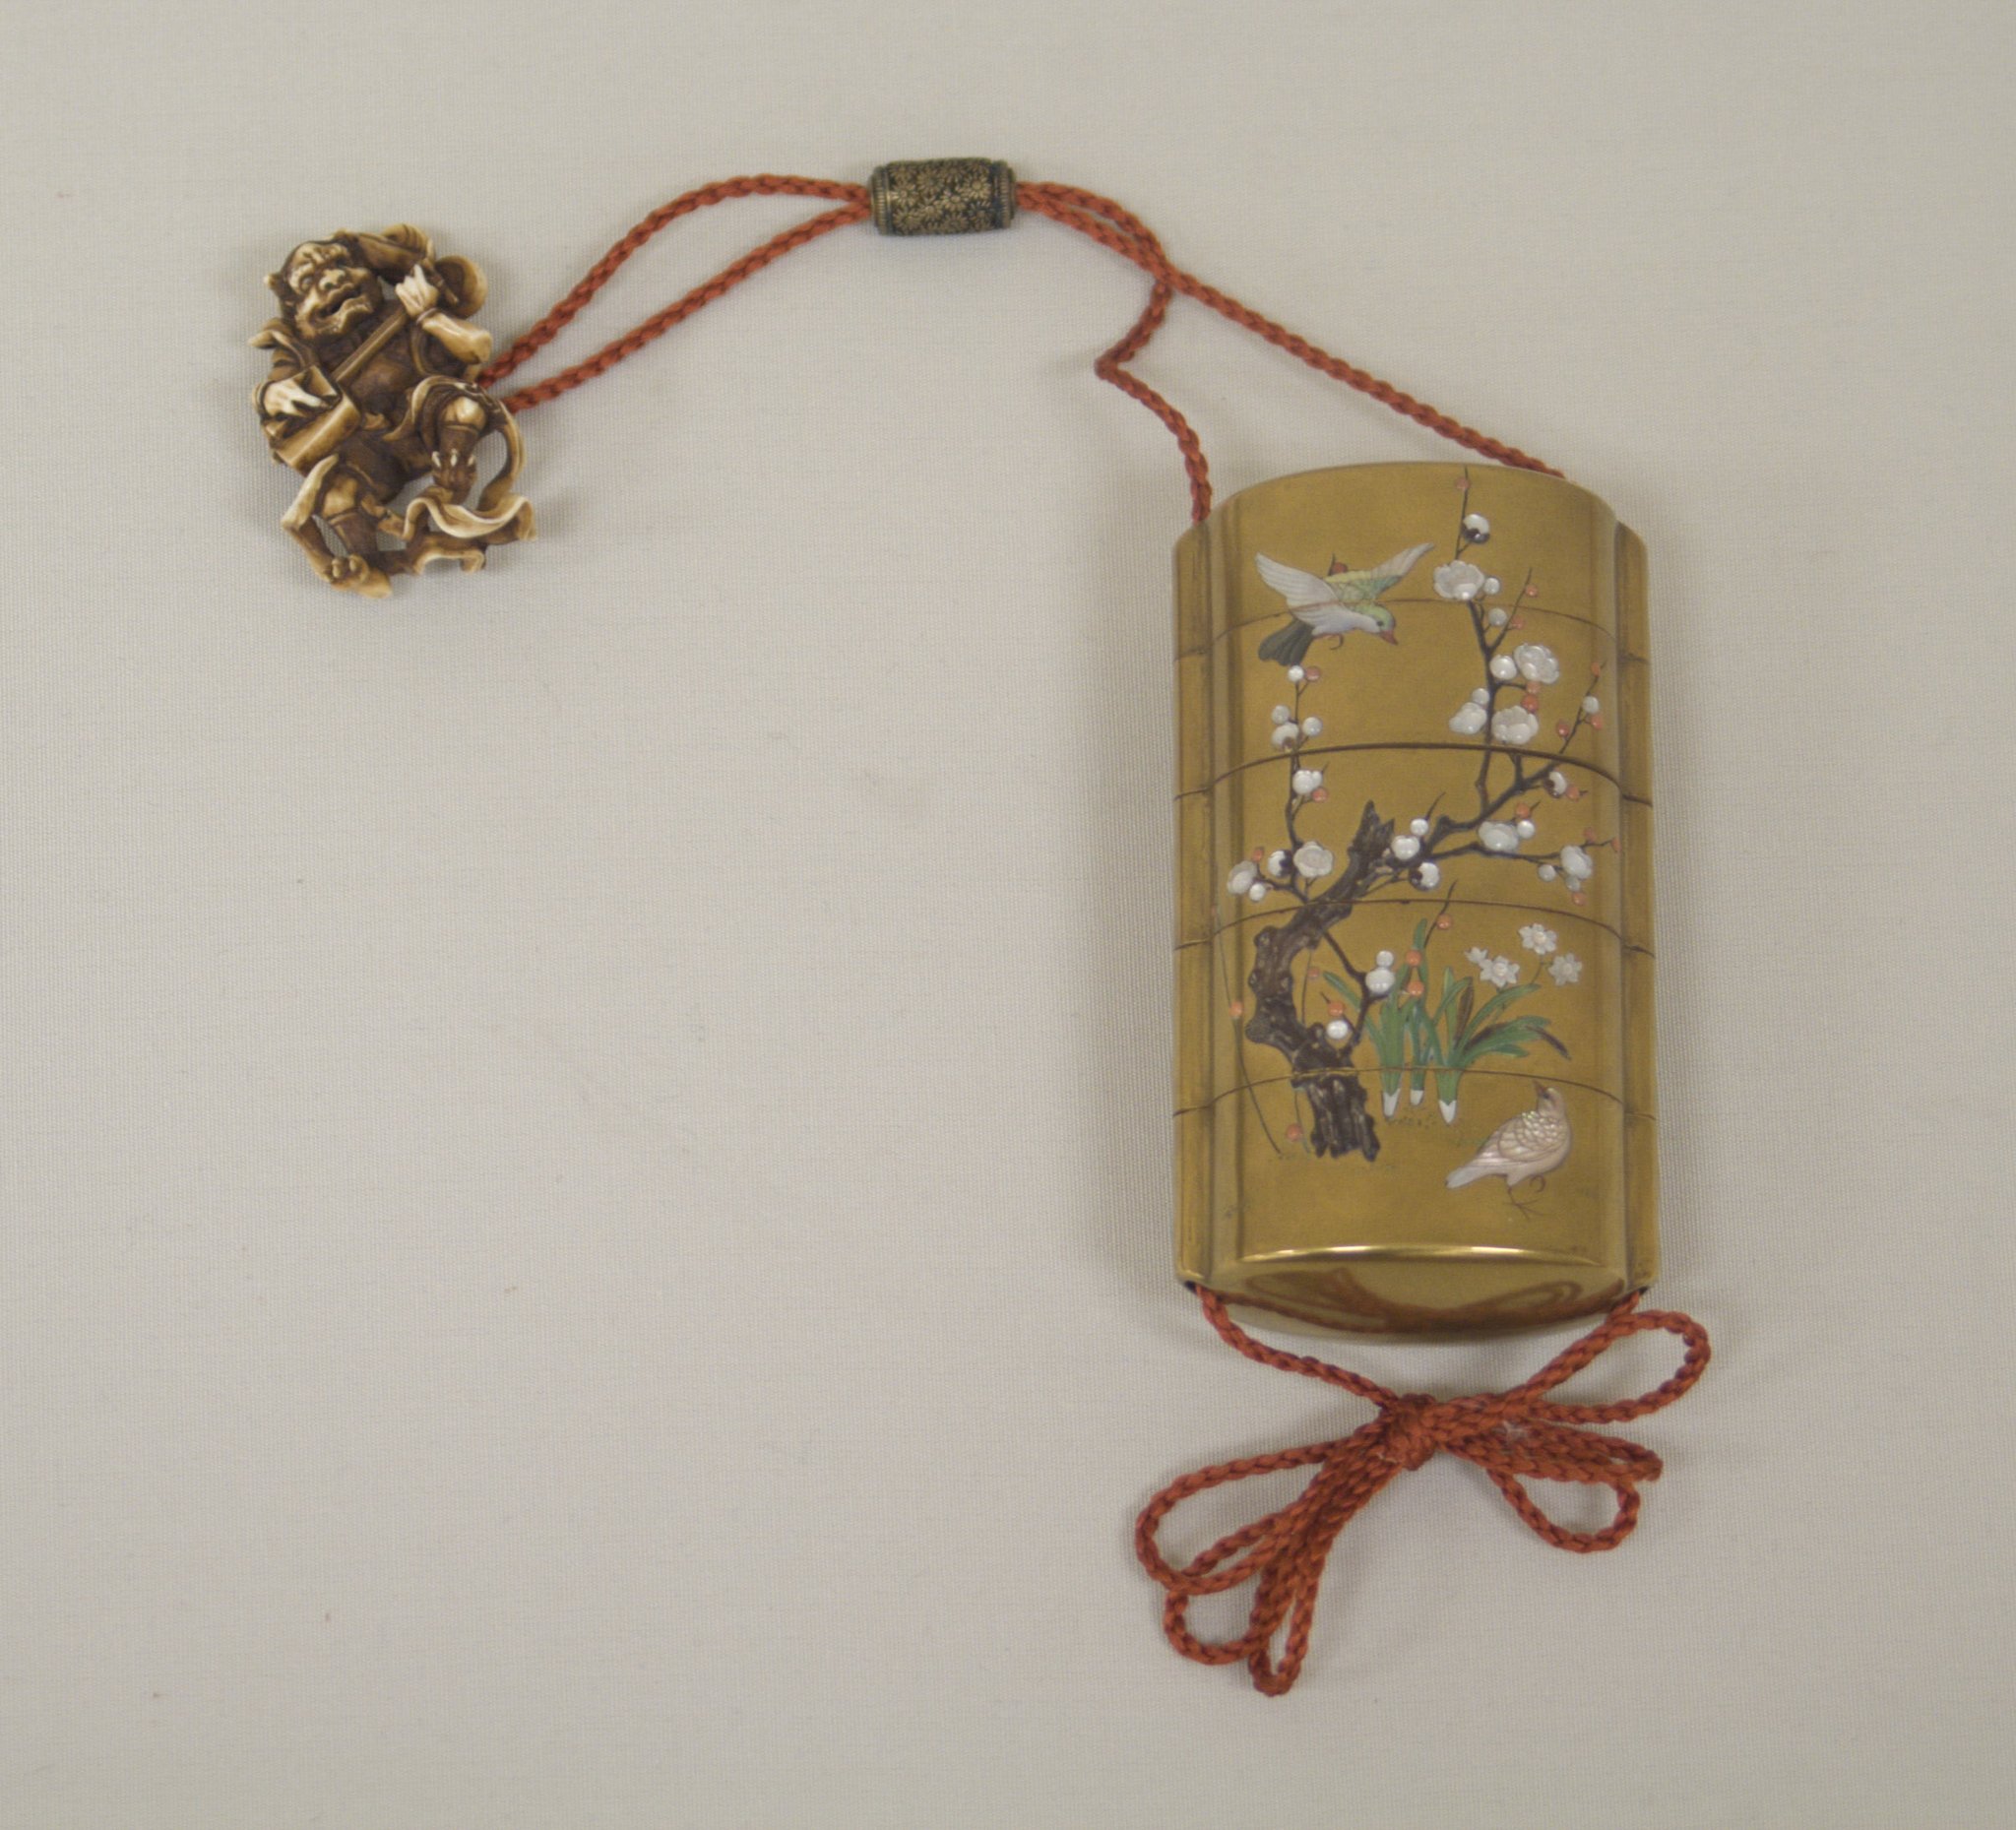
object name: inrō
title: Inrō with Birds, Plum, Chrysanthemum, and Loquat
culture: japanese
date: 1801-1900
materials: coral, gold, ivory, lacquer, mother of pearl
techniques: carving, inlay, stain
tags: birds,flowers